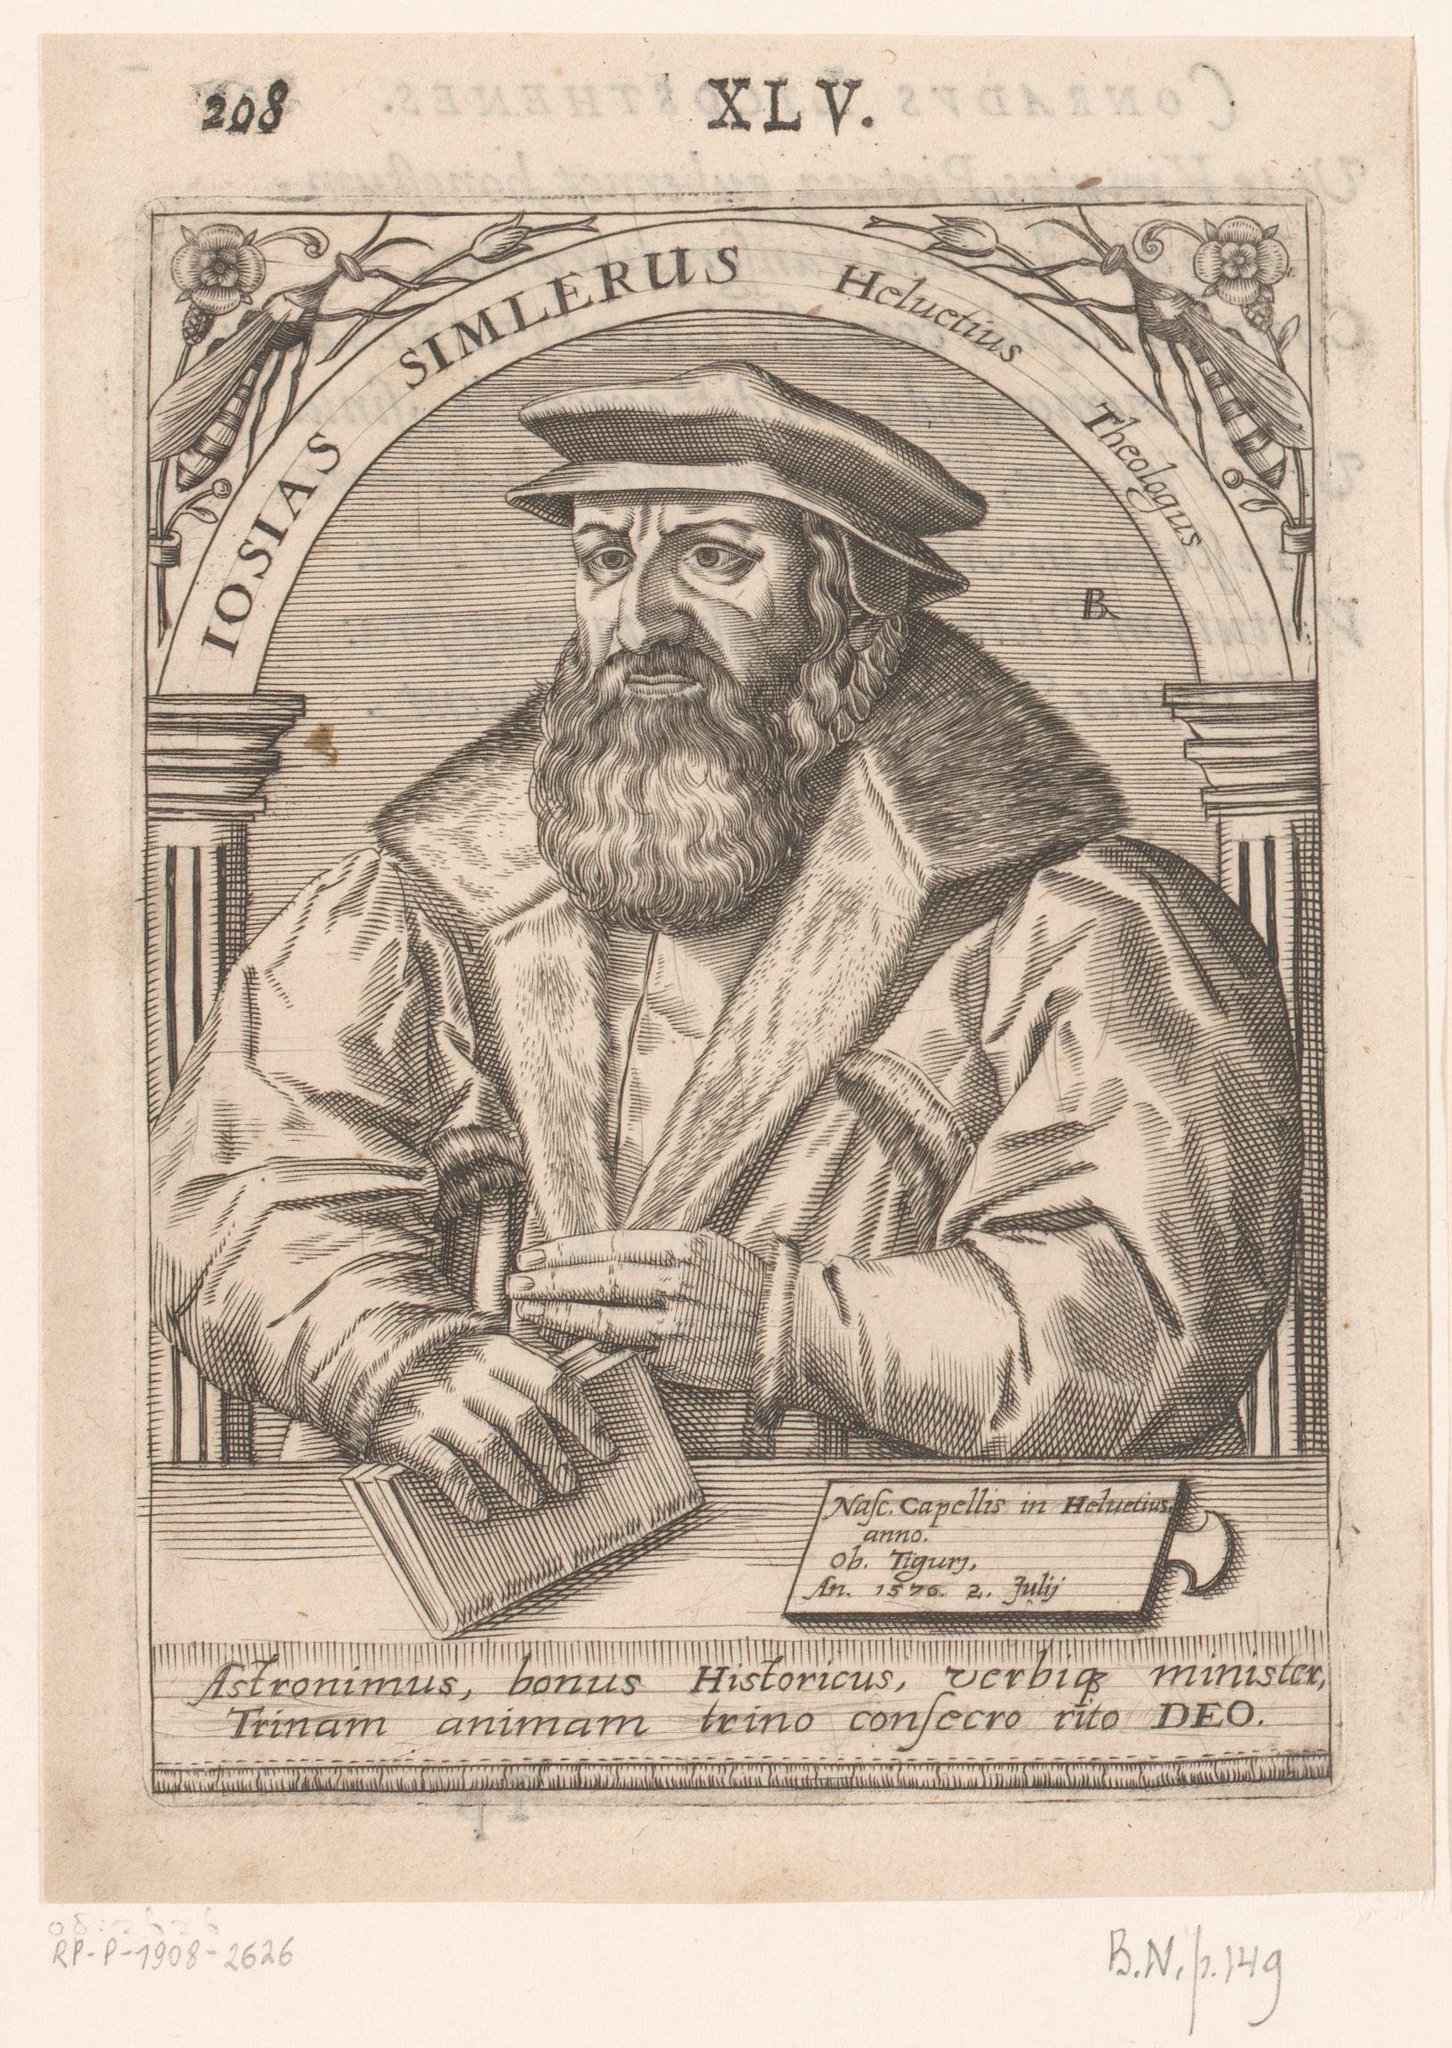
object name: book illustration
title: Portret van Josias Simmler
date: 1597-1599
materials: paper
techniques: engraving, letterpress printing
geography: france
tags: insects: wasp - ff - fabulous animals (sometimes wrongly called 'grotesques'); 'mostri' (ripa), historical persons, book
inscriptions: collector's mark: Lugt 2228